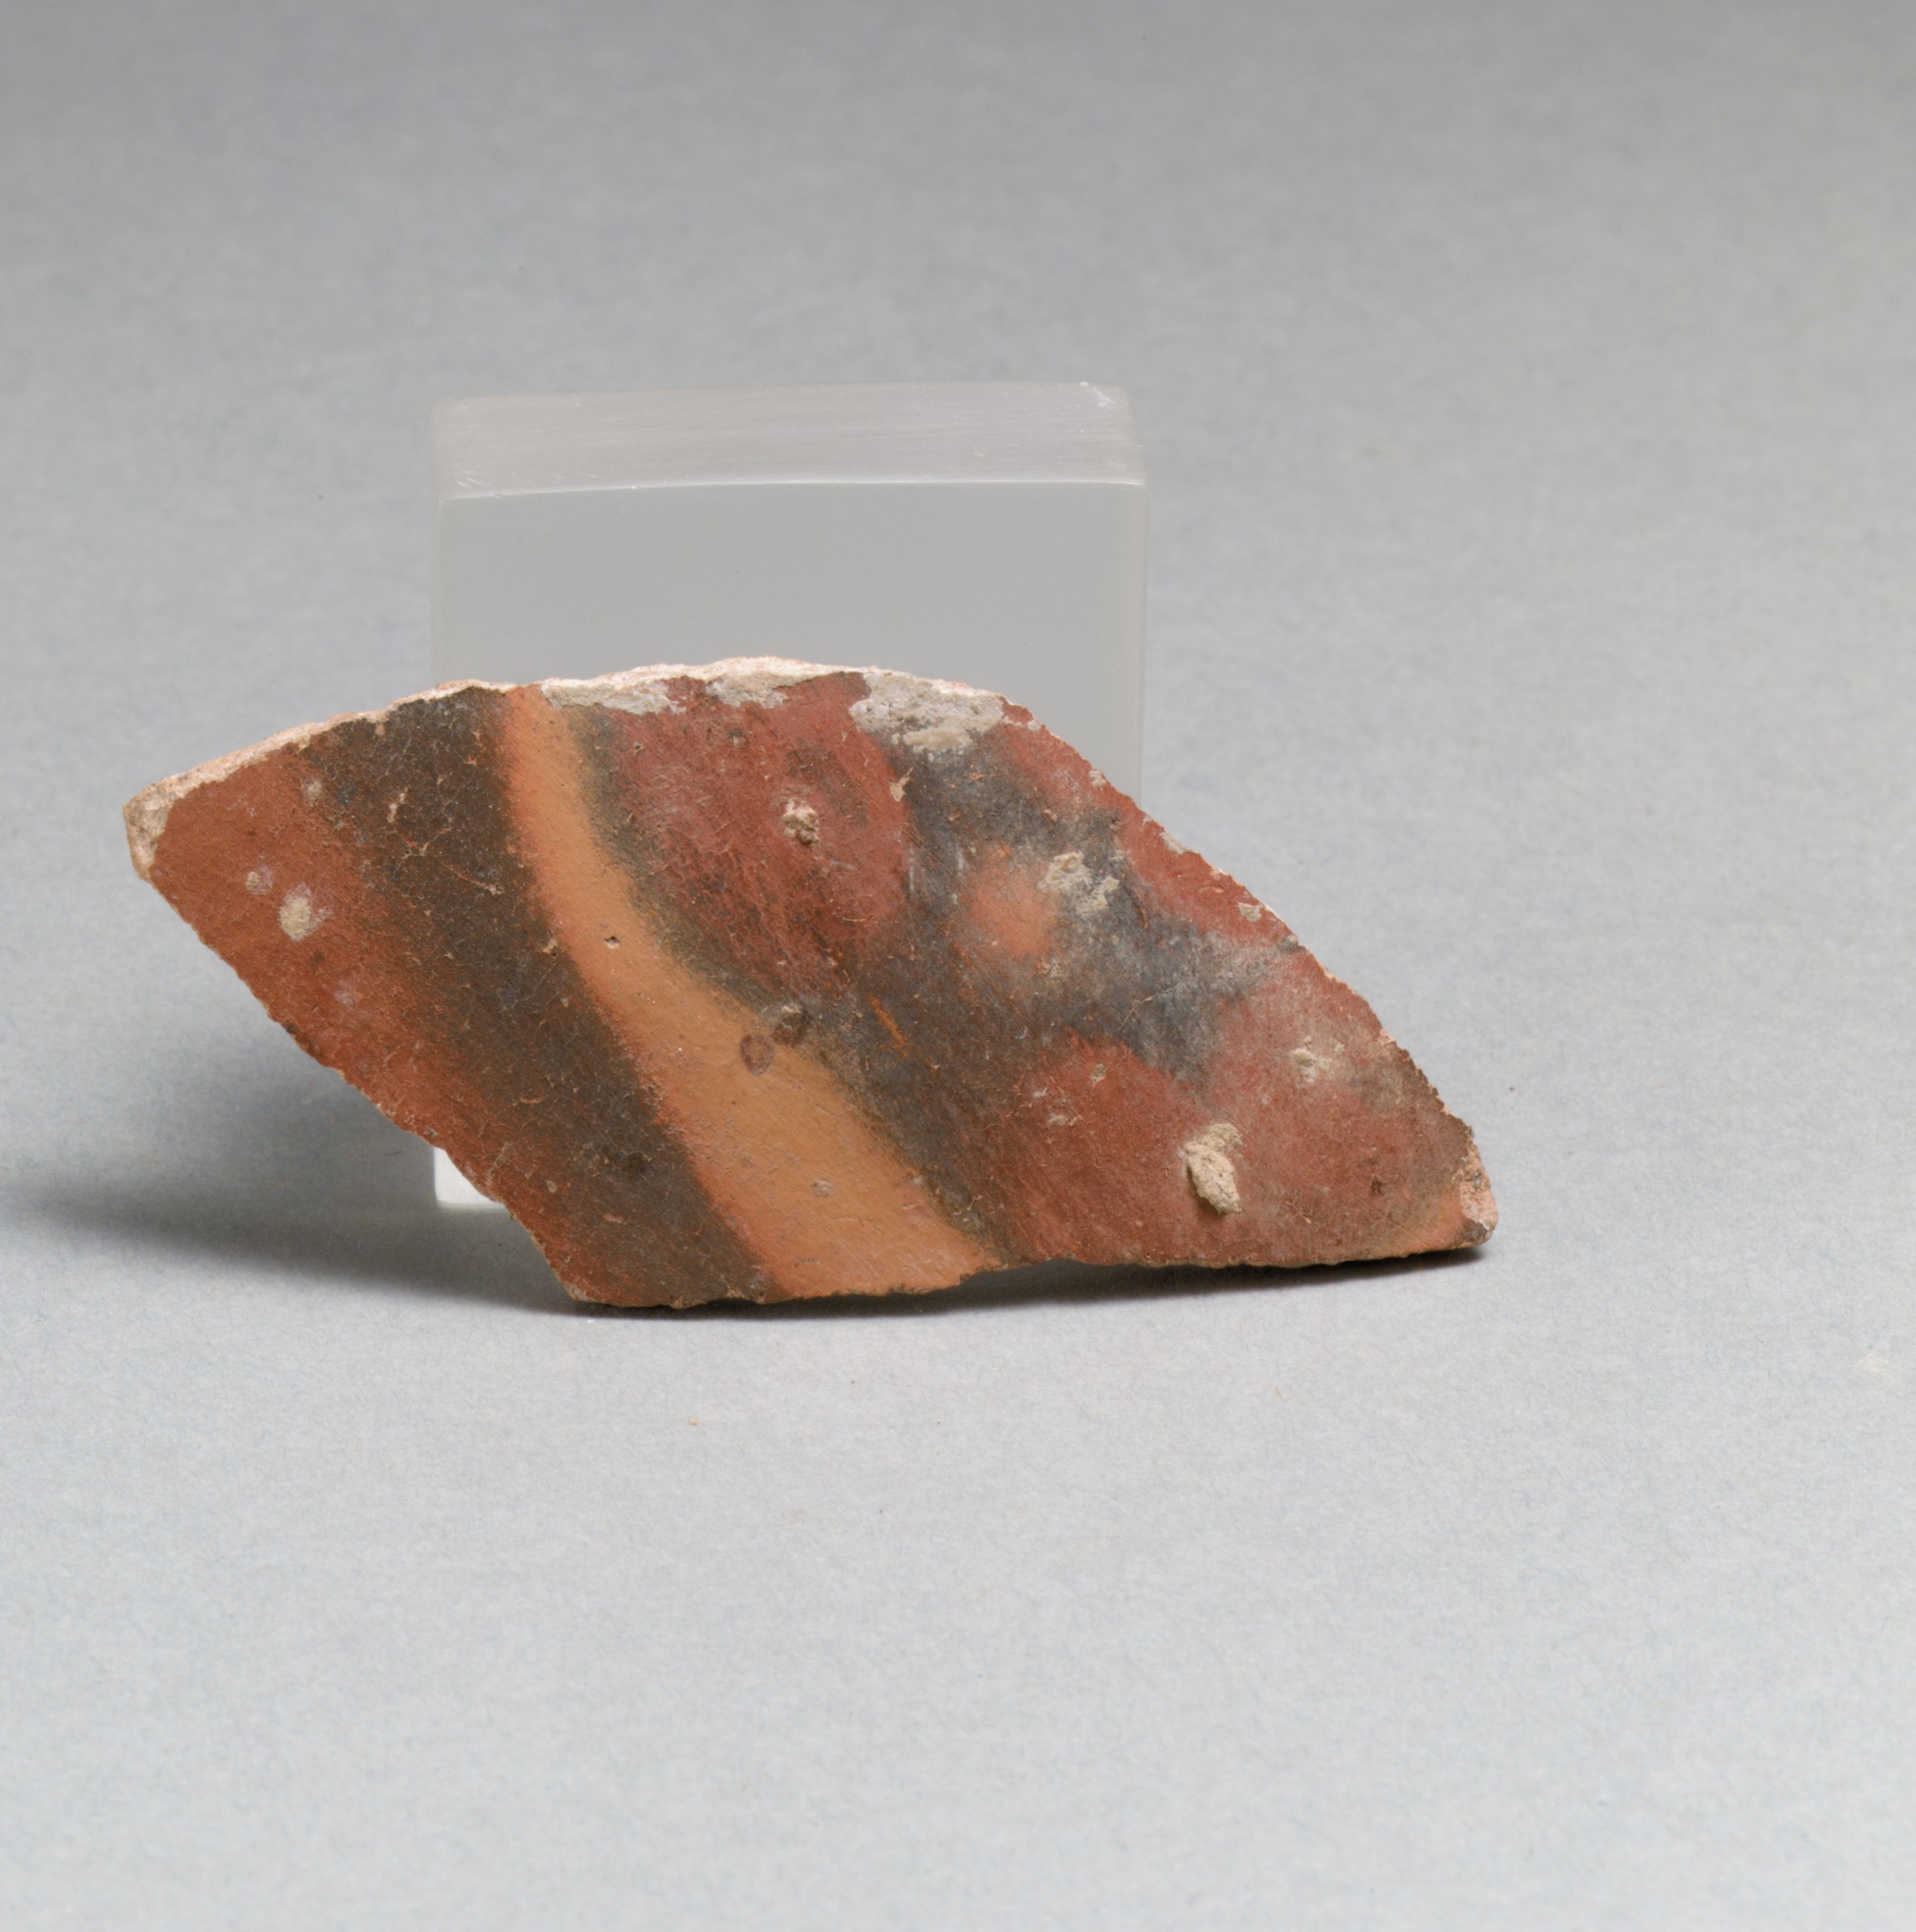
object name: vase fragment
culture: minoan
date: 2600-2000 BCE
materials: terracotta